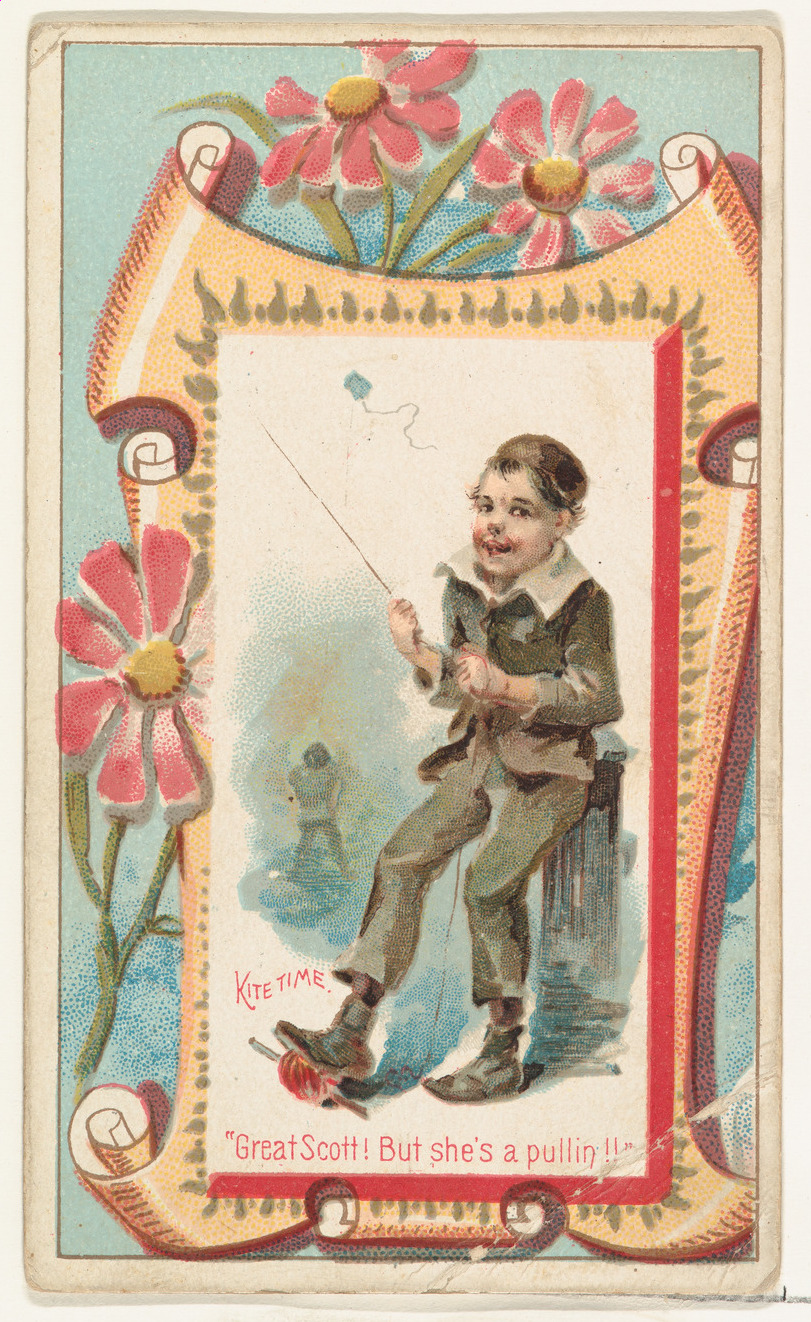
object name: print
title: Kite Time, "Great Scott! But she's a pullin!!" from the Terrors of America set (N136) issued by Duke Sons & Co. to promote Honest Long Cut Tobacco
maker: w. duke, sons & co.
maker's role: publisher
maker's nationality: american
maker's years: 1870-1920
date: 1888-1889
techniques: color lithograph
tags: boys